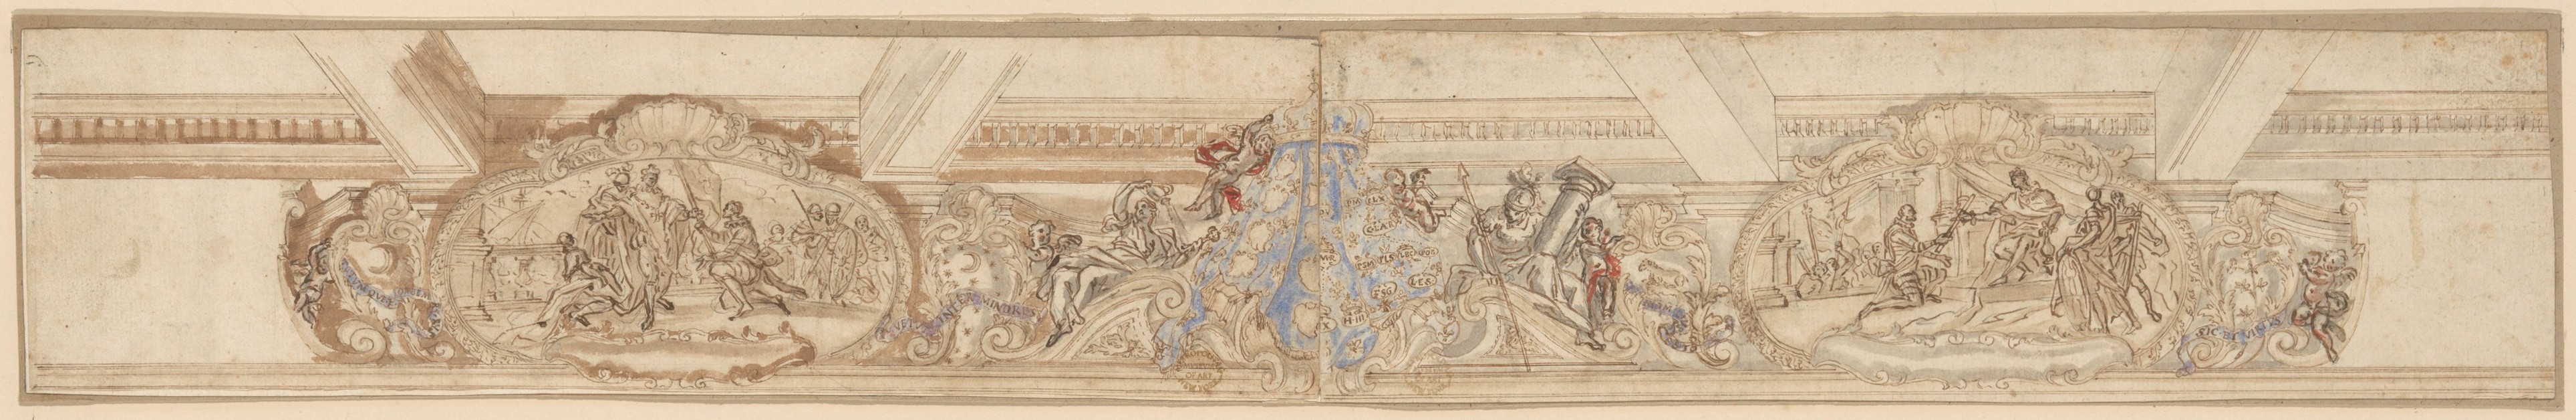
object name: collection ornament architecture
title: Decoration for Frieze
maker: anonymous, french, 16th century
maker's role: artist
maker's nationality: french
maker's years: 1500-1600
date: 1501-1600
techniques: pen, tinting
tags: human figures,ornament